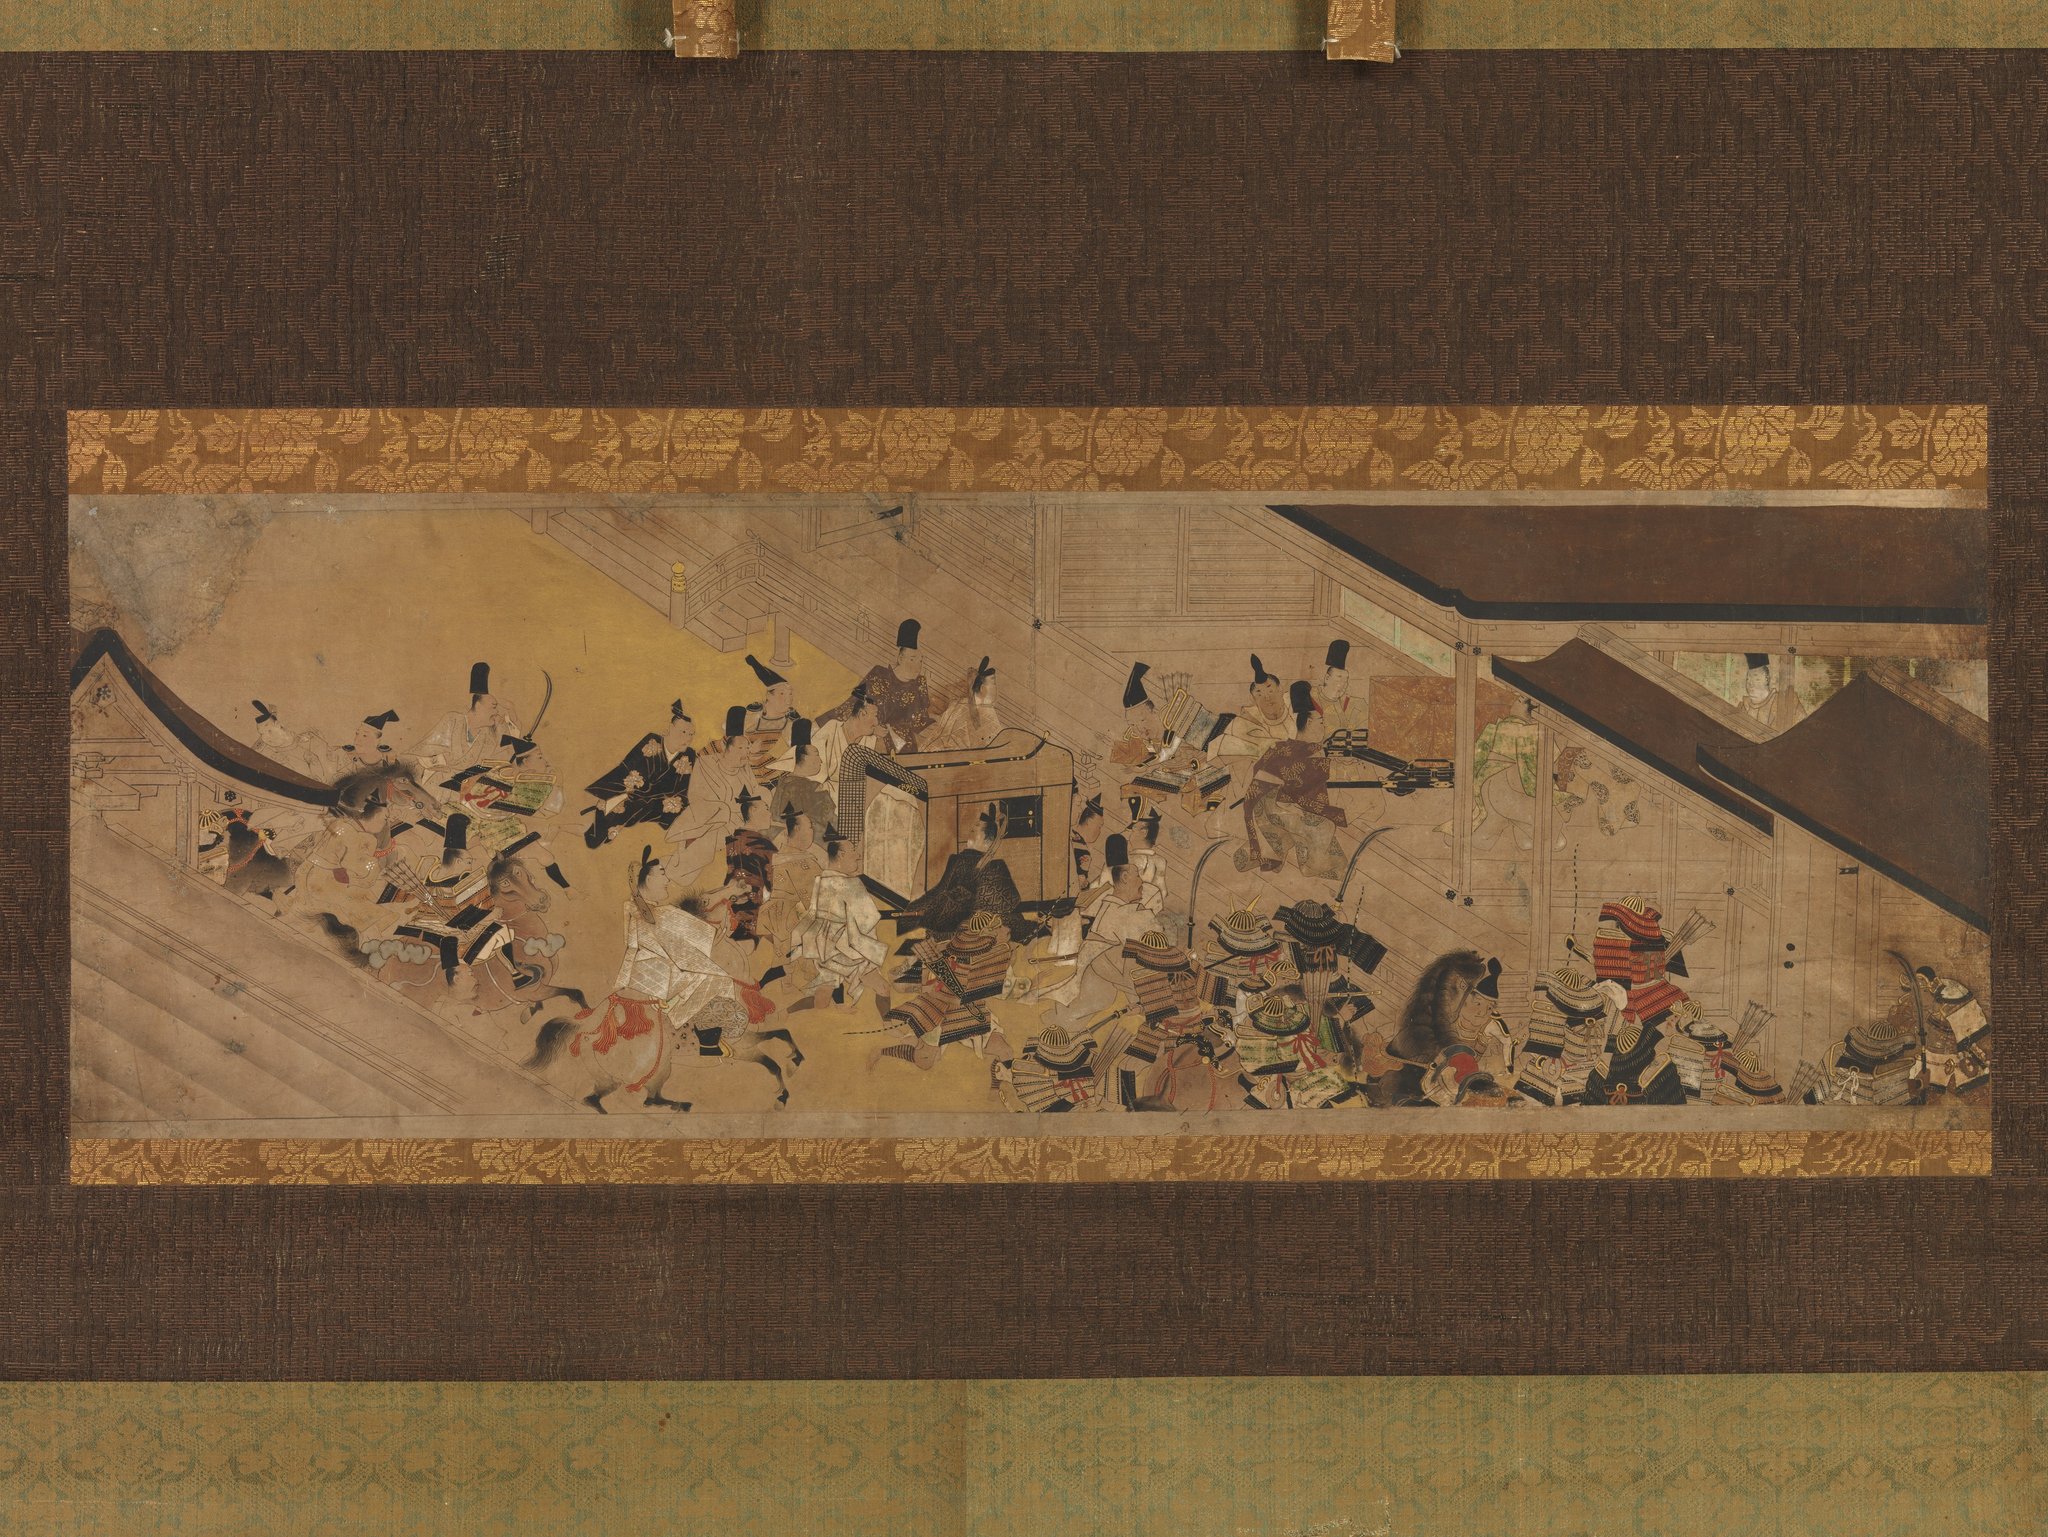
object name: hanging scroll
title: Scene from “Imperial Visit to Rokuhara,” from The Tale of the Heiji Rebellion (Heiji monogatari)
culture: japanese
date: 1701-1800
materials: ink, paper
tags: soldiers,men,horses